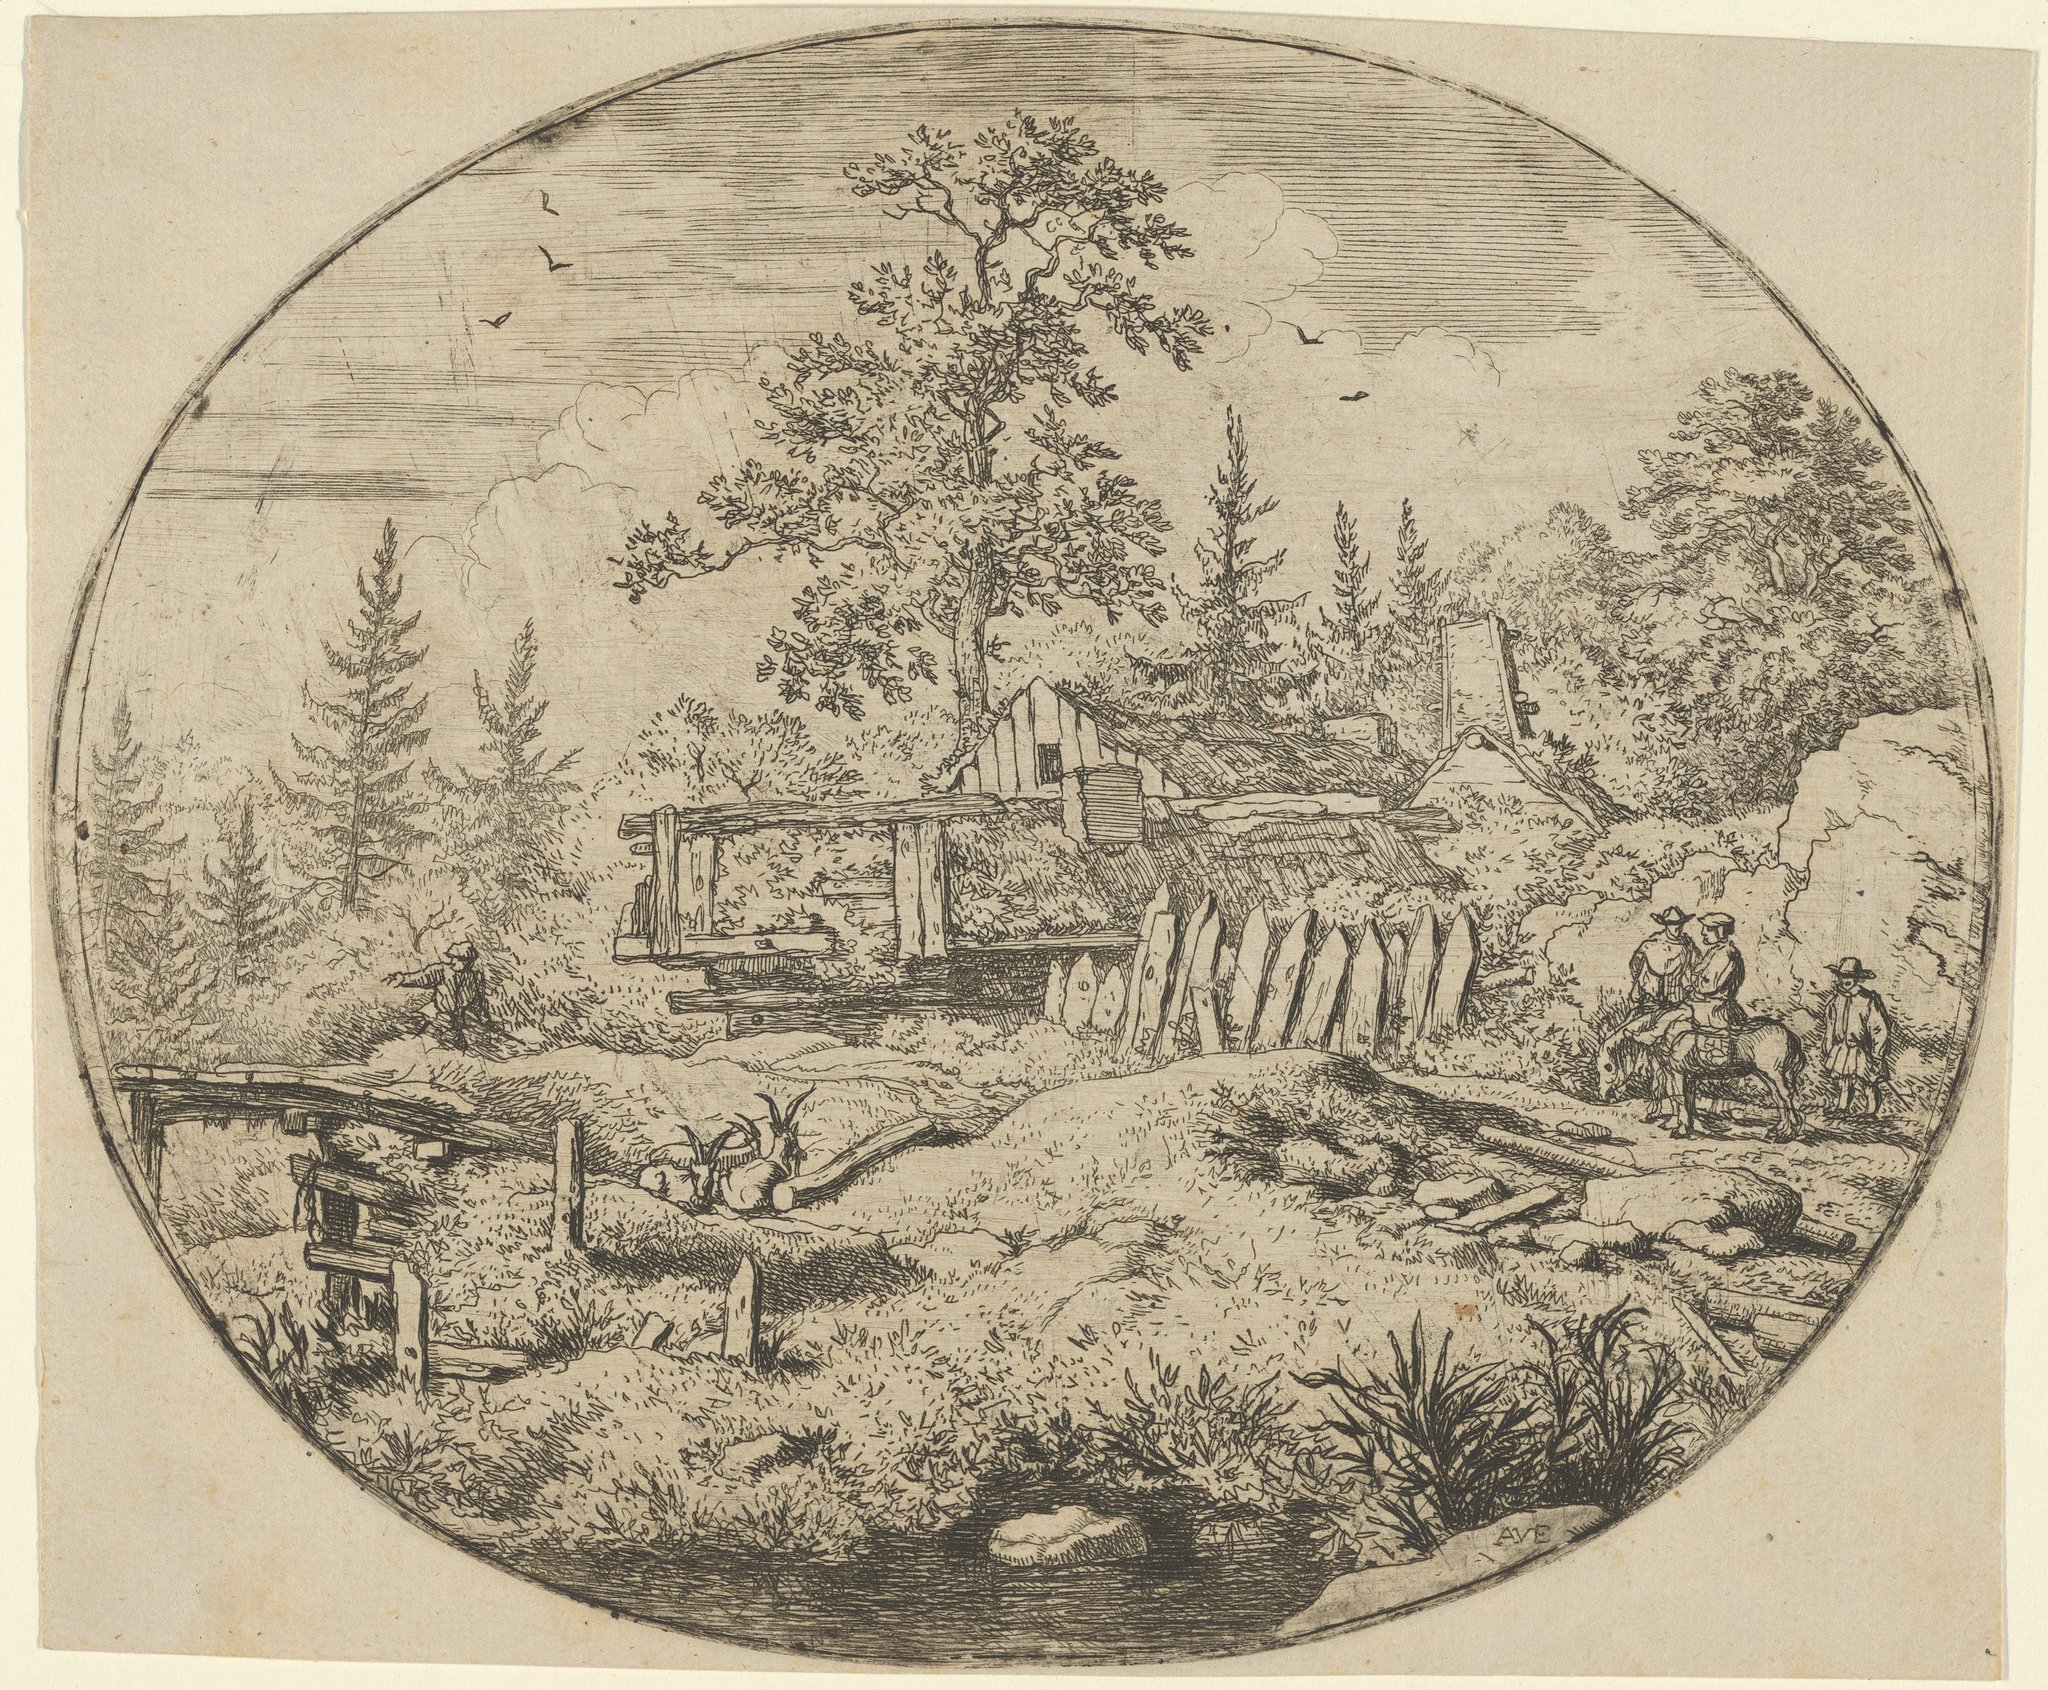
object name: print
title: The Landscape with the Wooden Bridge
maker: allart van everdingen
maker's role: artist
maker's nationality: dutch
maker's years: 1621-1675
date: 1621-1675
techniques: engraving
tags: animals,bridges,men,landscapes,trees